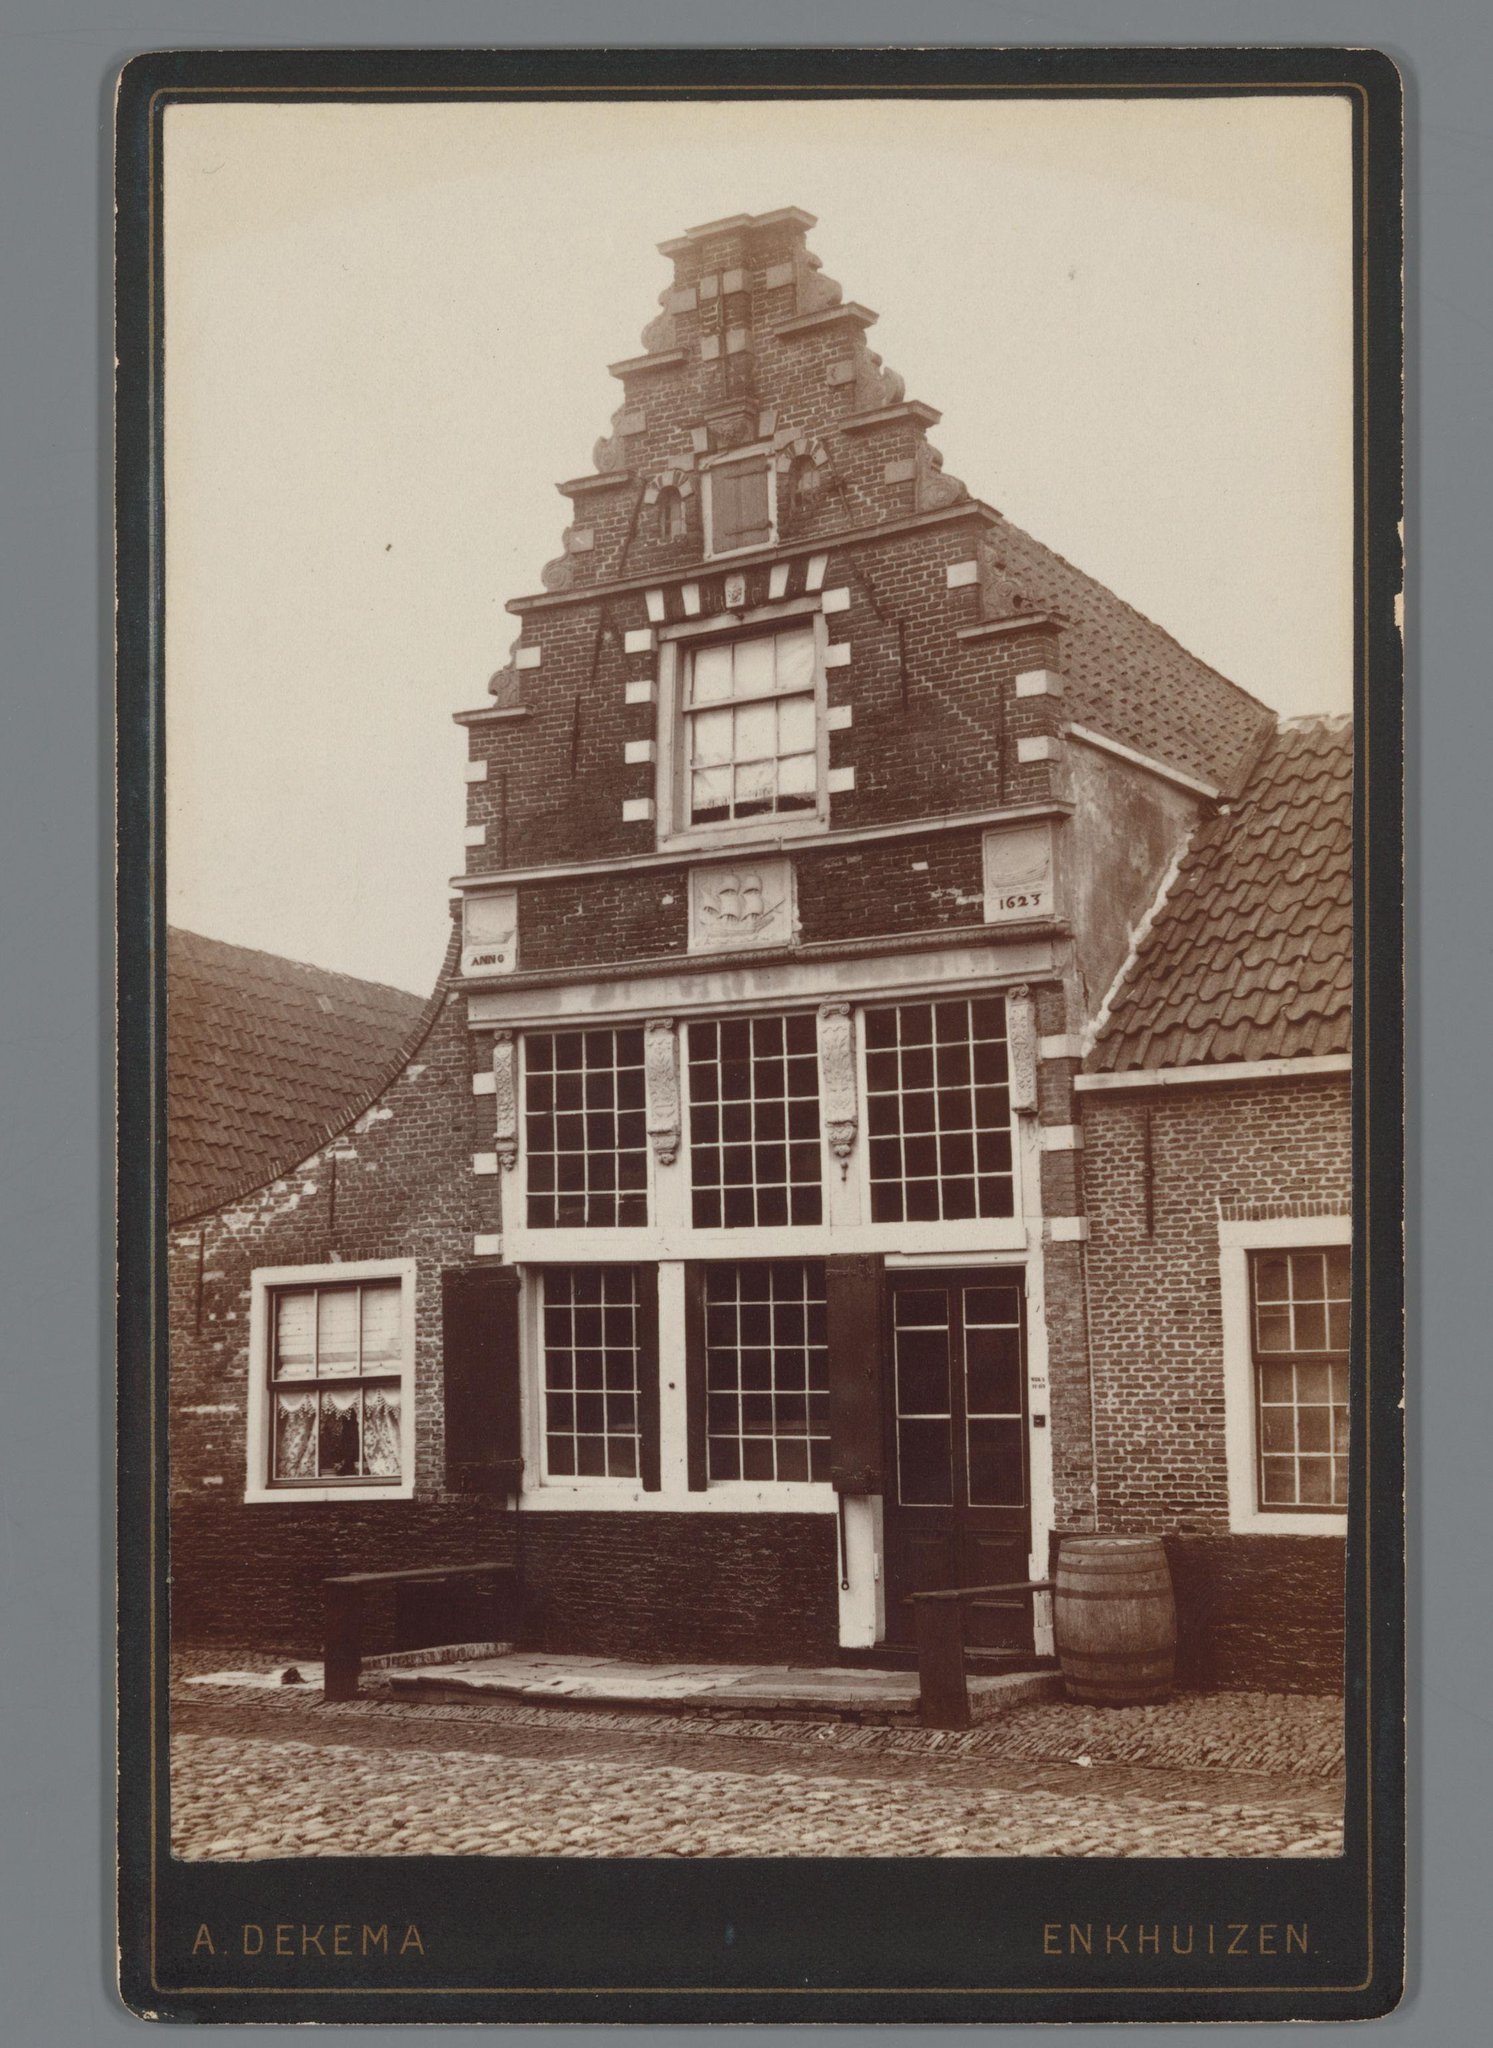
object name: photograph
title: Gevel aan de Breedstraat te Enkhuizen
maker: albert dekema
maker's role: publisher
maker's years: 1824-1909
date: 1865-1896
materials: cardboard, photographic support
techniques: albumen print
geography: enkhuizen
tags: urban housing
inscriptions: annotation: ‘Gevel aan de Breedstraat 1623’